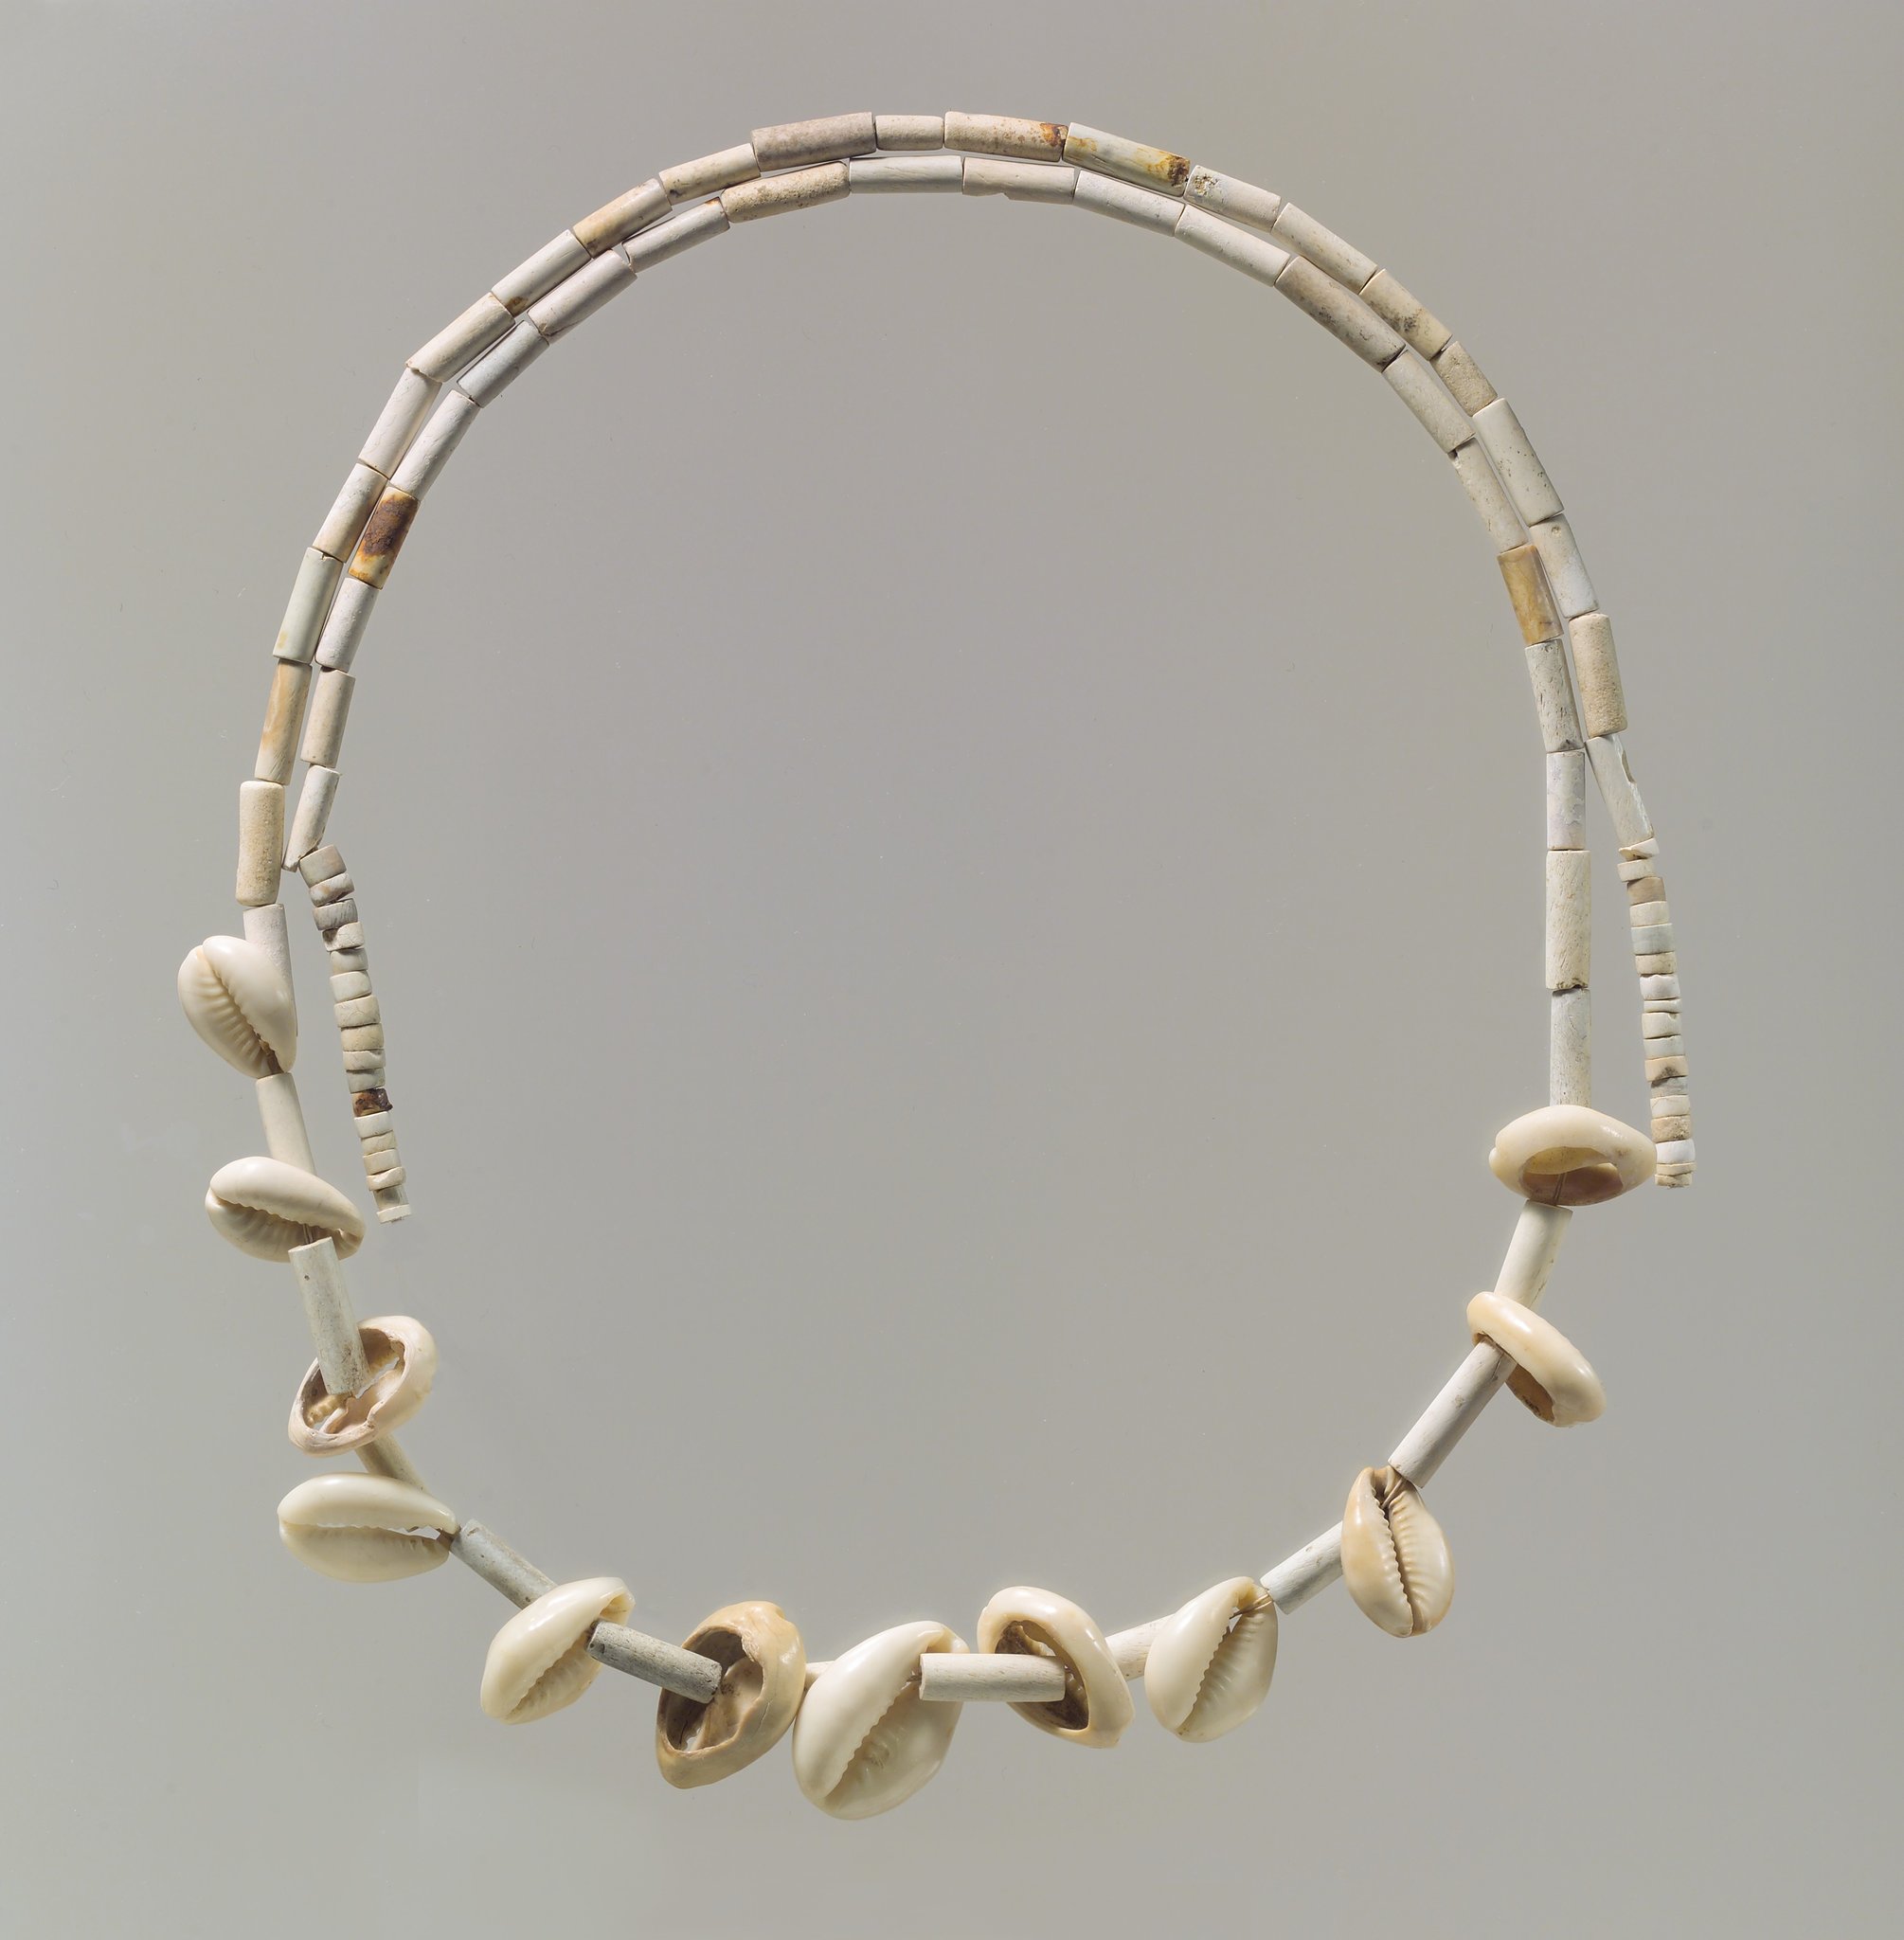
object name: bead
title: Beads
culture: iranian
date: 900-801 BCE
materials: shell, stone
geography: iran